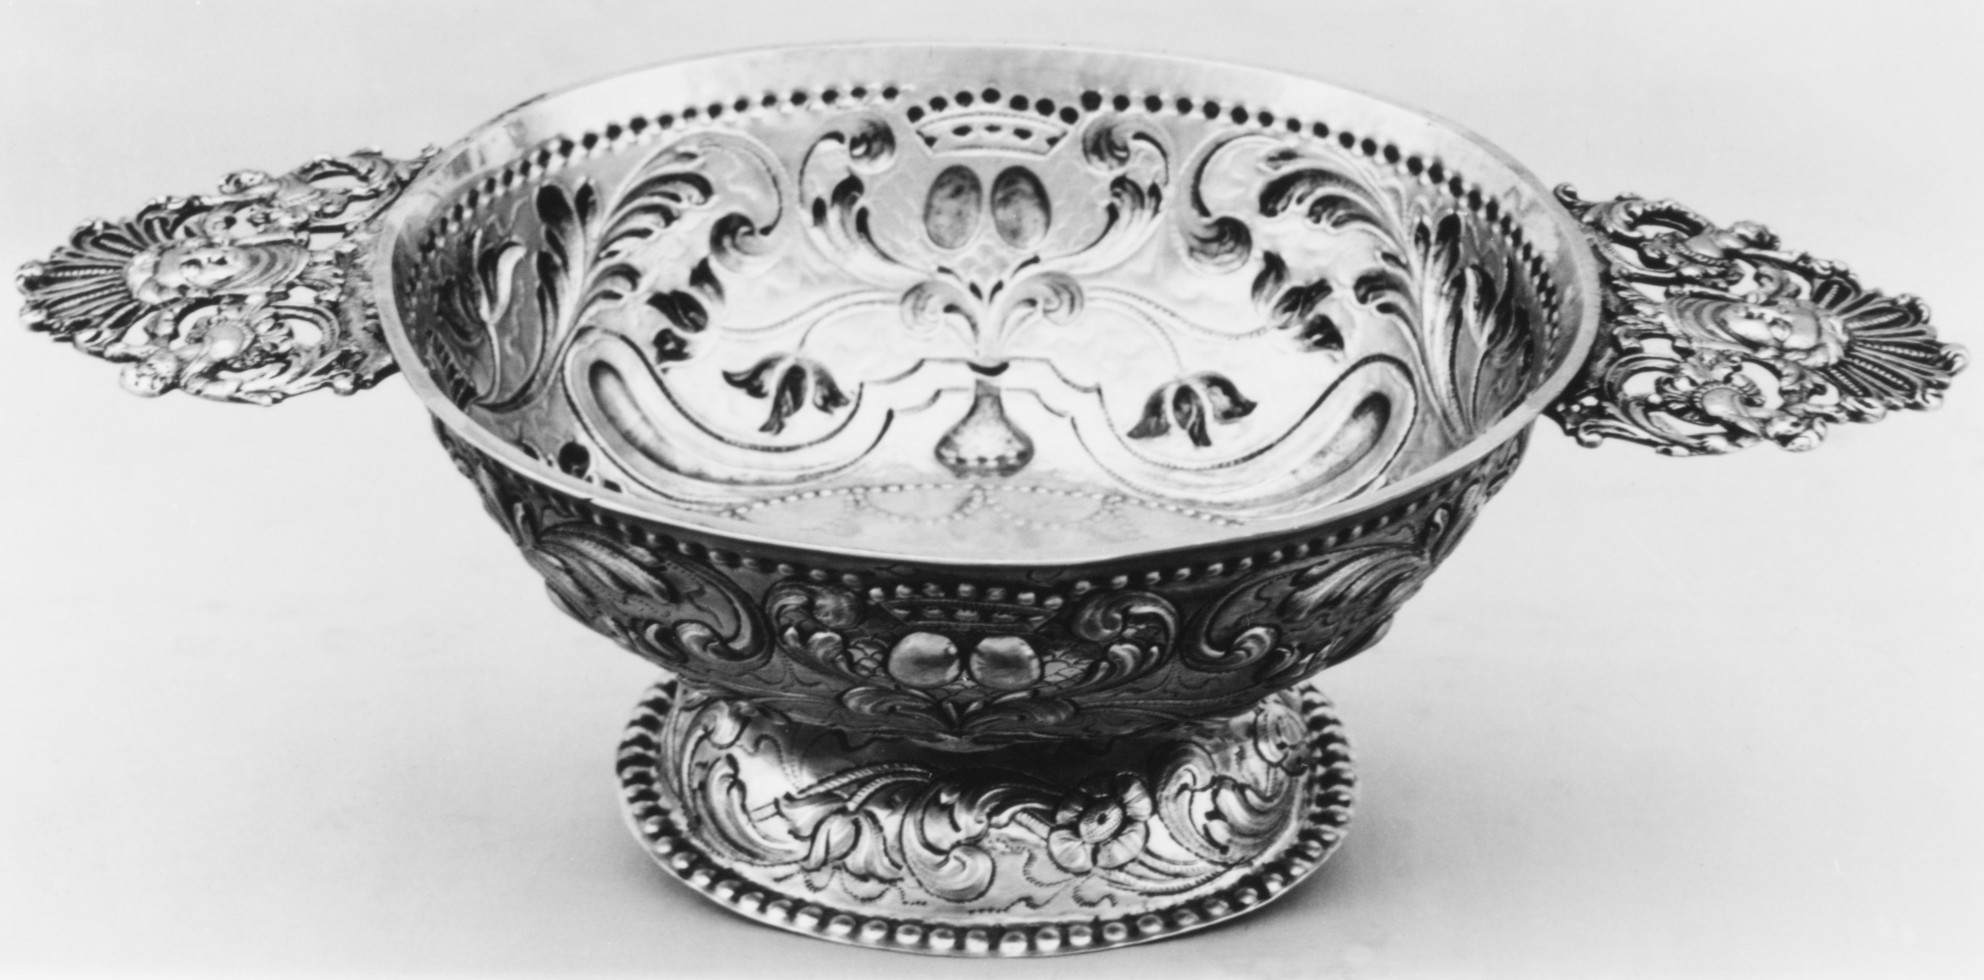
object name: bowl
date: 1737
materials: silver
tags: flowers